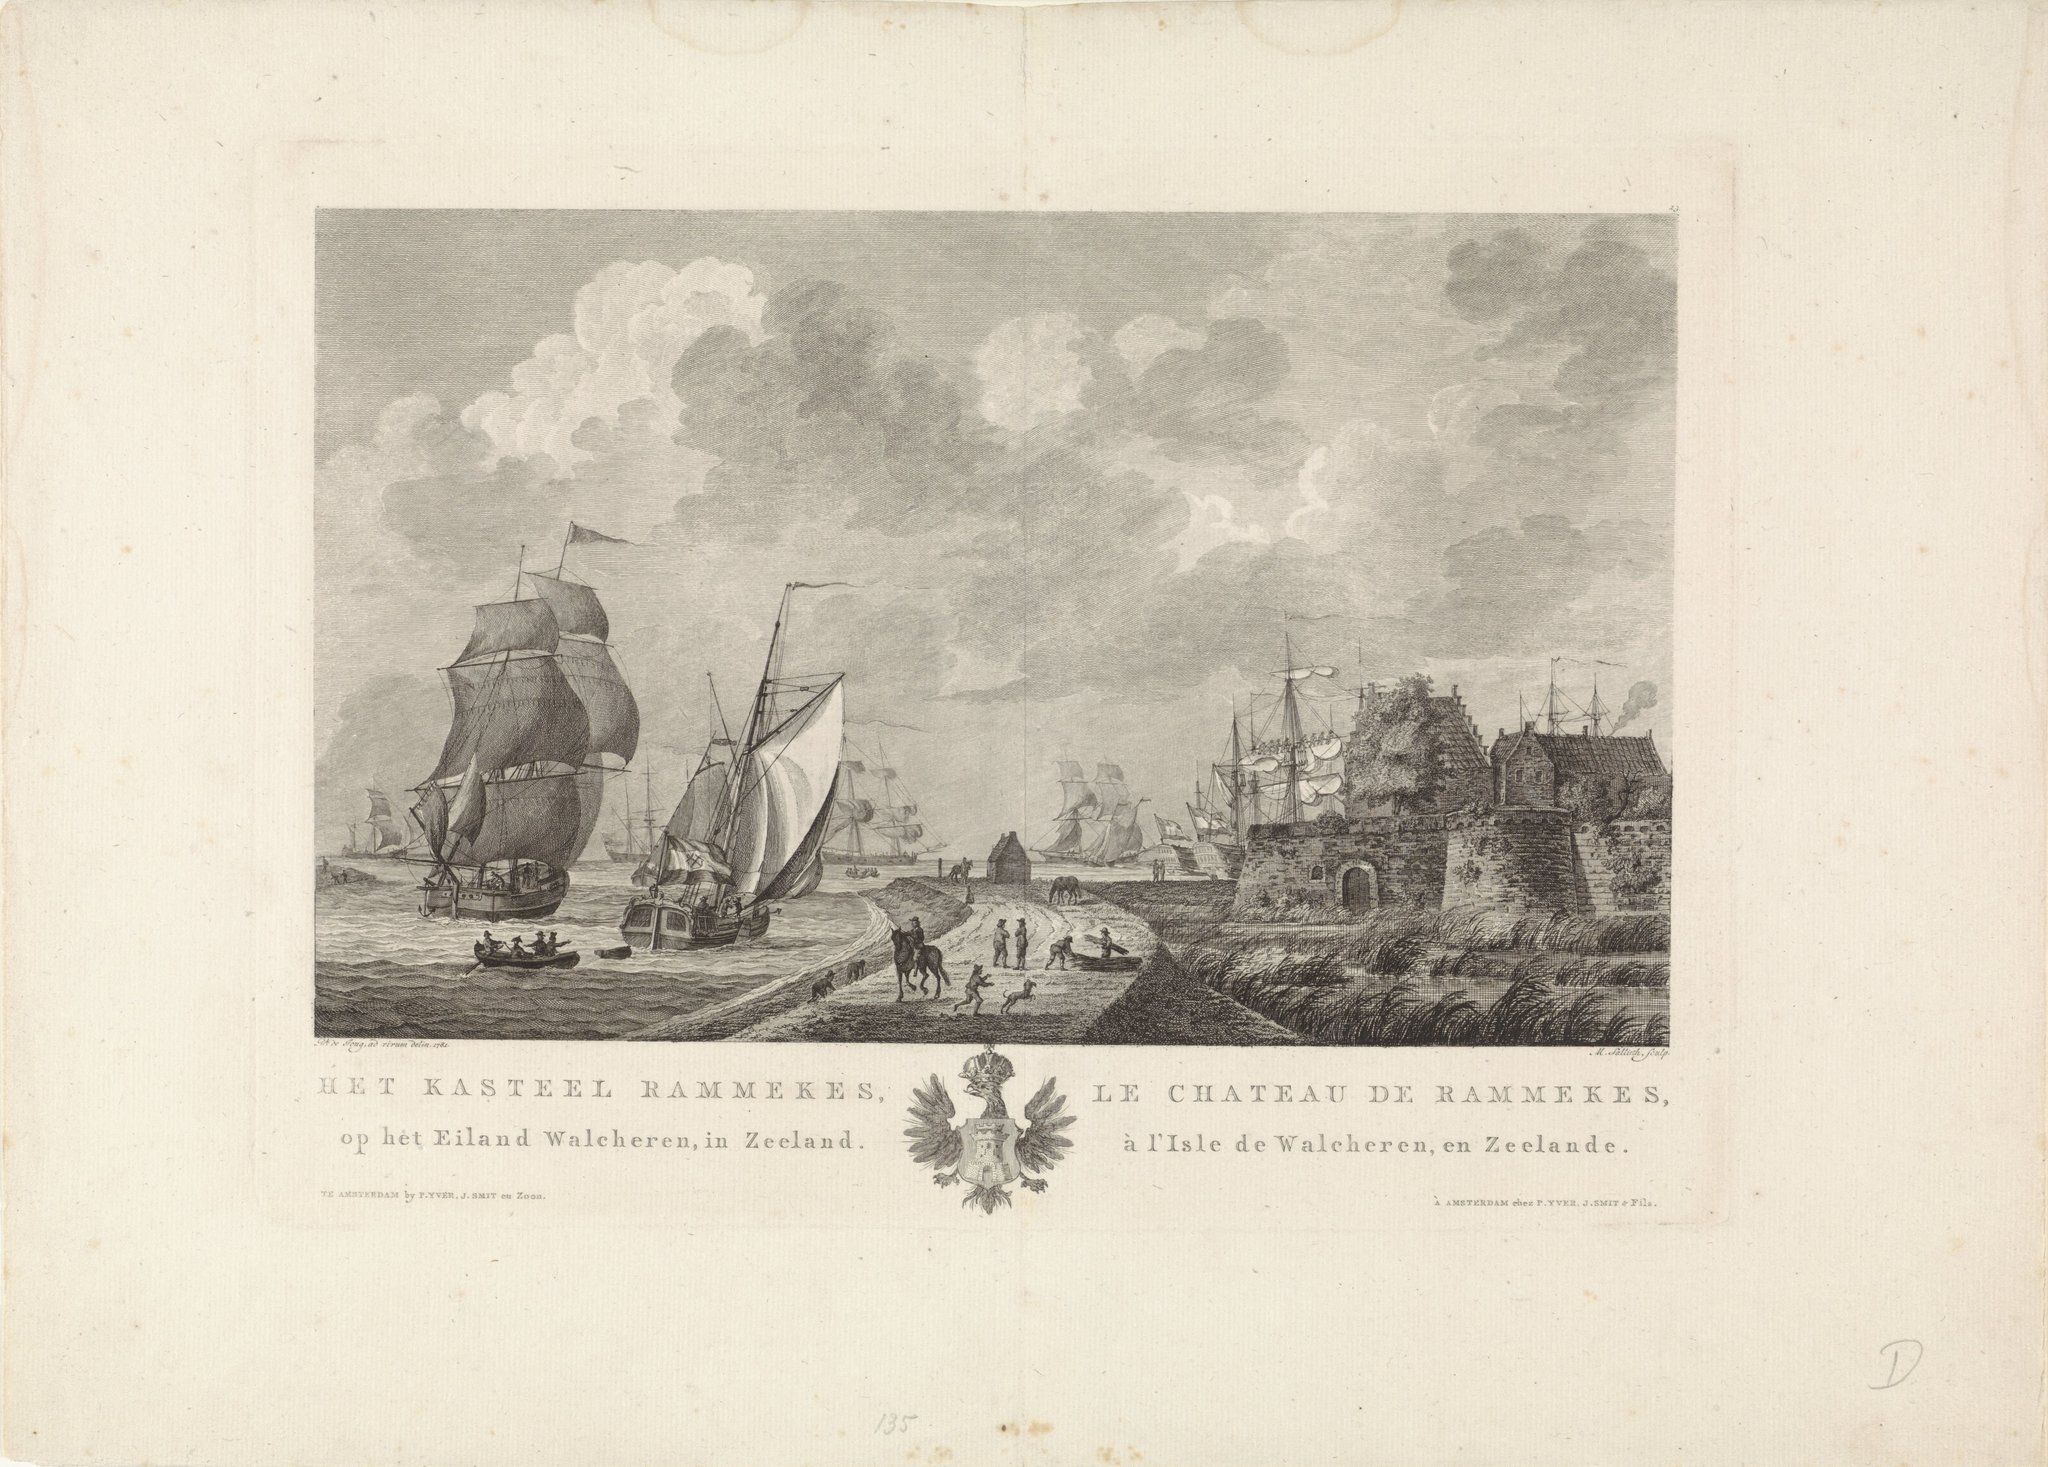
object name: print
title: Gezicht op fort Rammekens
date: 1781-1785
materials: paper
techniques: etching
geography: rotterdam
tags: fortress, coat of arms (as symbol of the state, etc.) (+ city; municipal), sailing-ship, sailing-boat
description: Gezicht op Fort Rammekens te Zeeland. Op de rede van het fort liggen verschillende schepen. In de marge het wapen van Zeeland. Prent rechtsboven genummerd: 23.